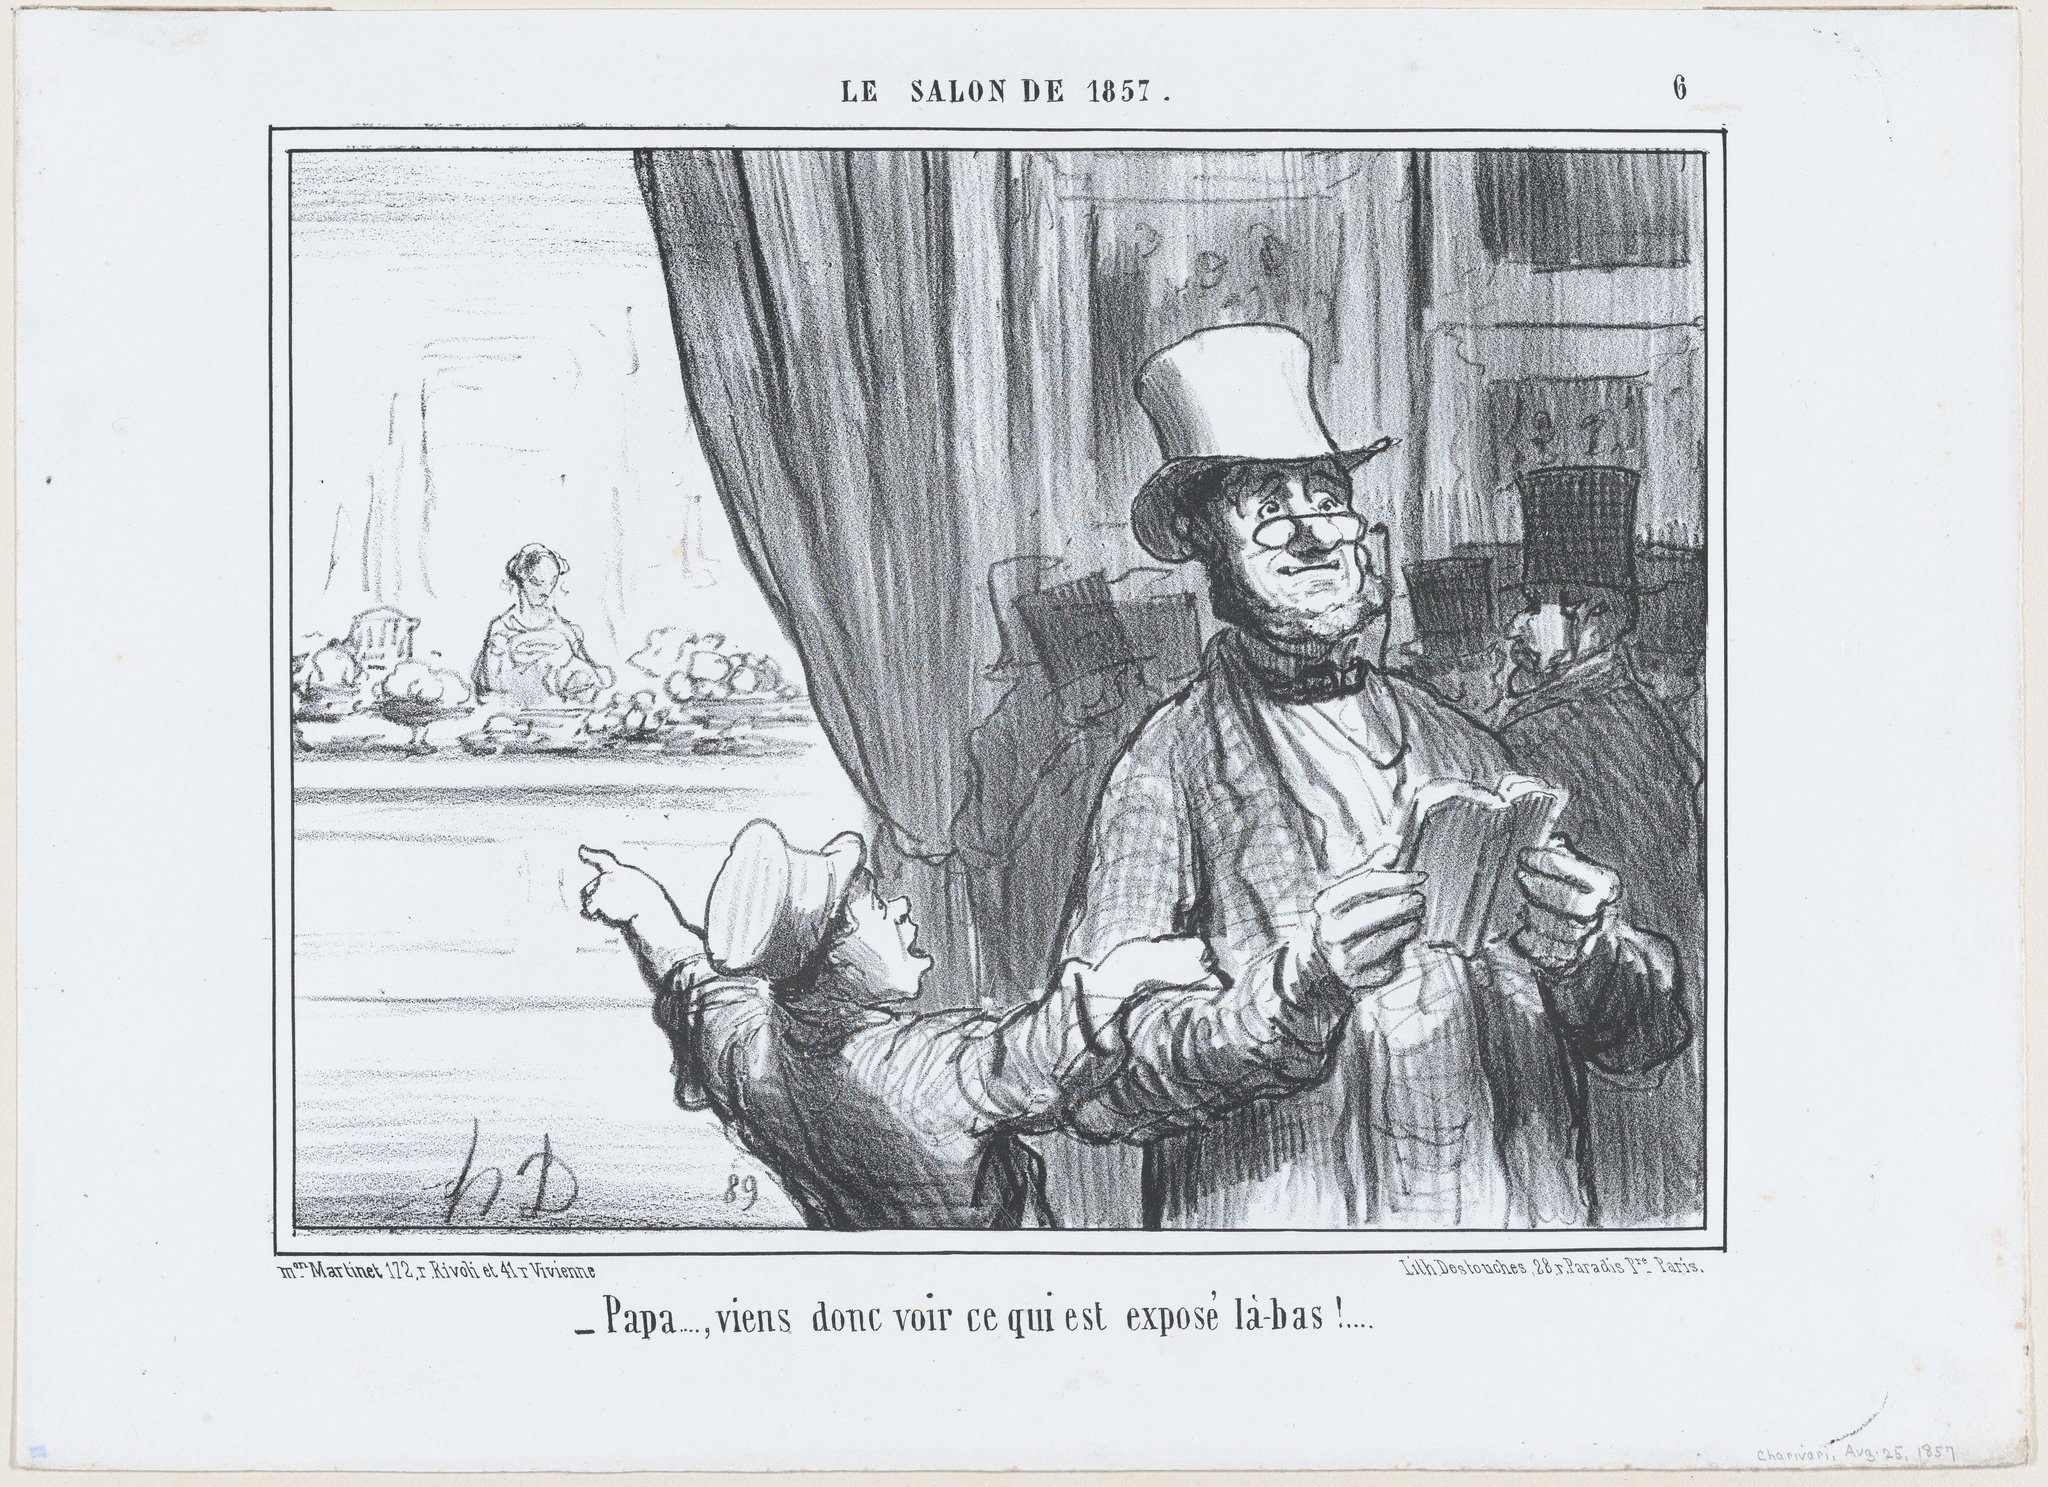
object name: print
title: Papa...., viens donc voir ce qui est exposé là-bas!....', from Le Salon de 1857, published in "Le Charivari"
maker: honoré daumier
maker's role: artist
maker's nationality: french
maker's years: 1808-1879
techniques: lithograph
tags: boys,men,fathers,reading